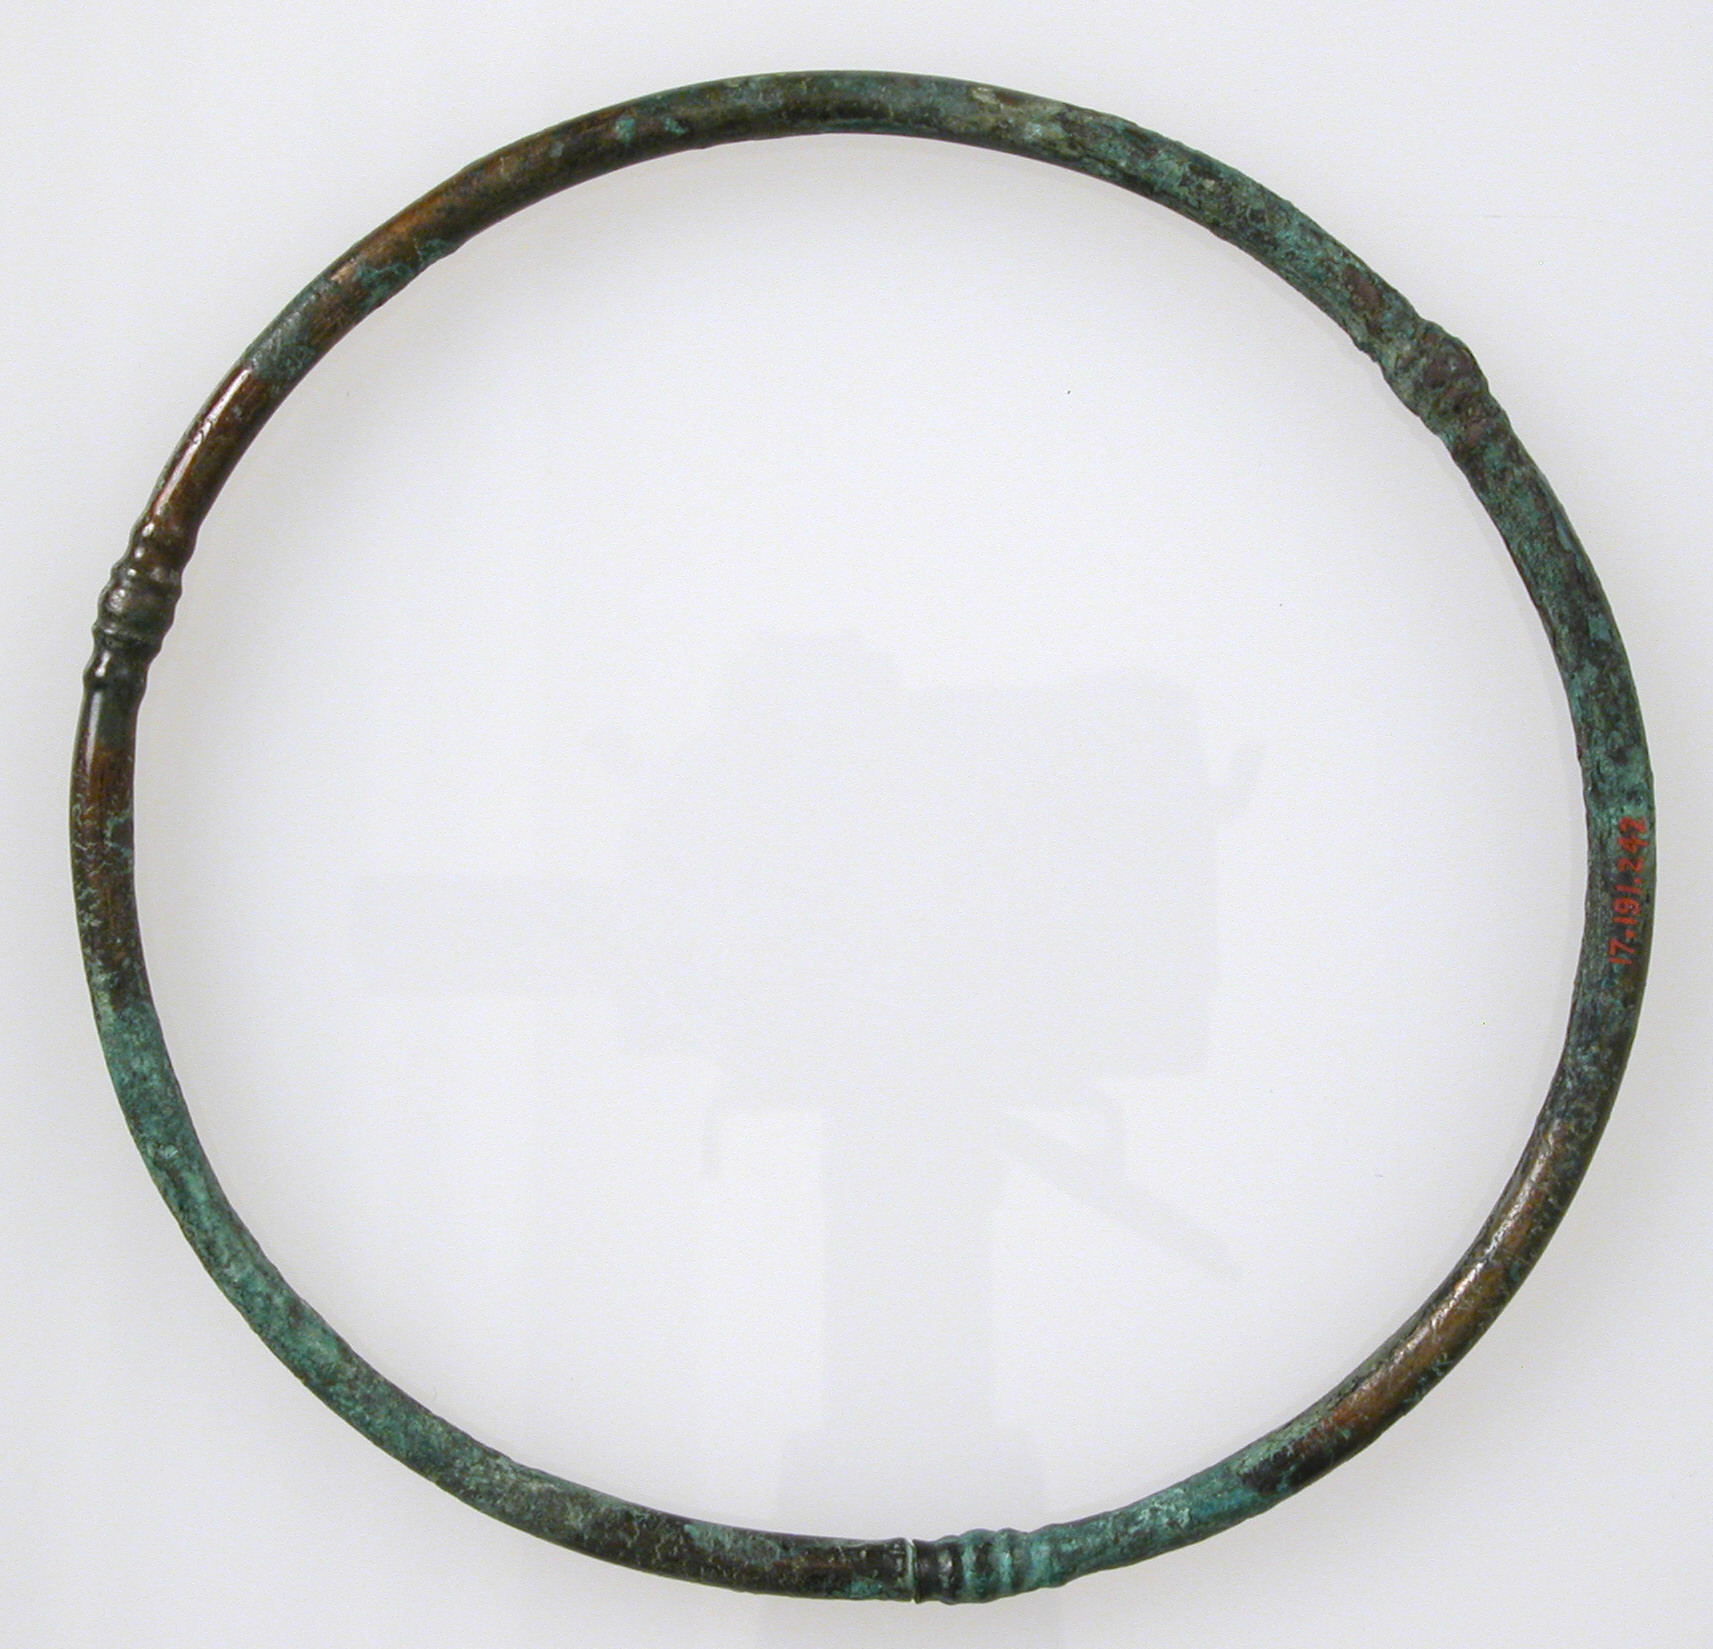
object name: torc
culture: celtic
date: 400-201 BCE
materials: copper alloy